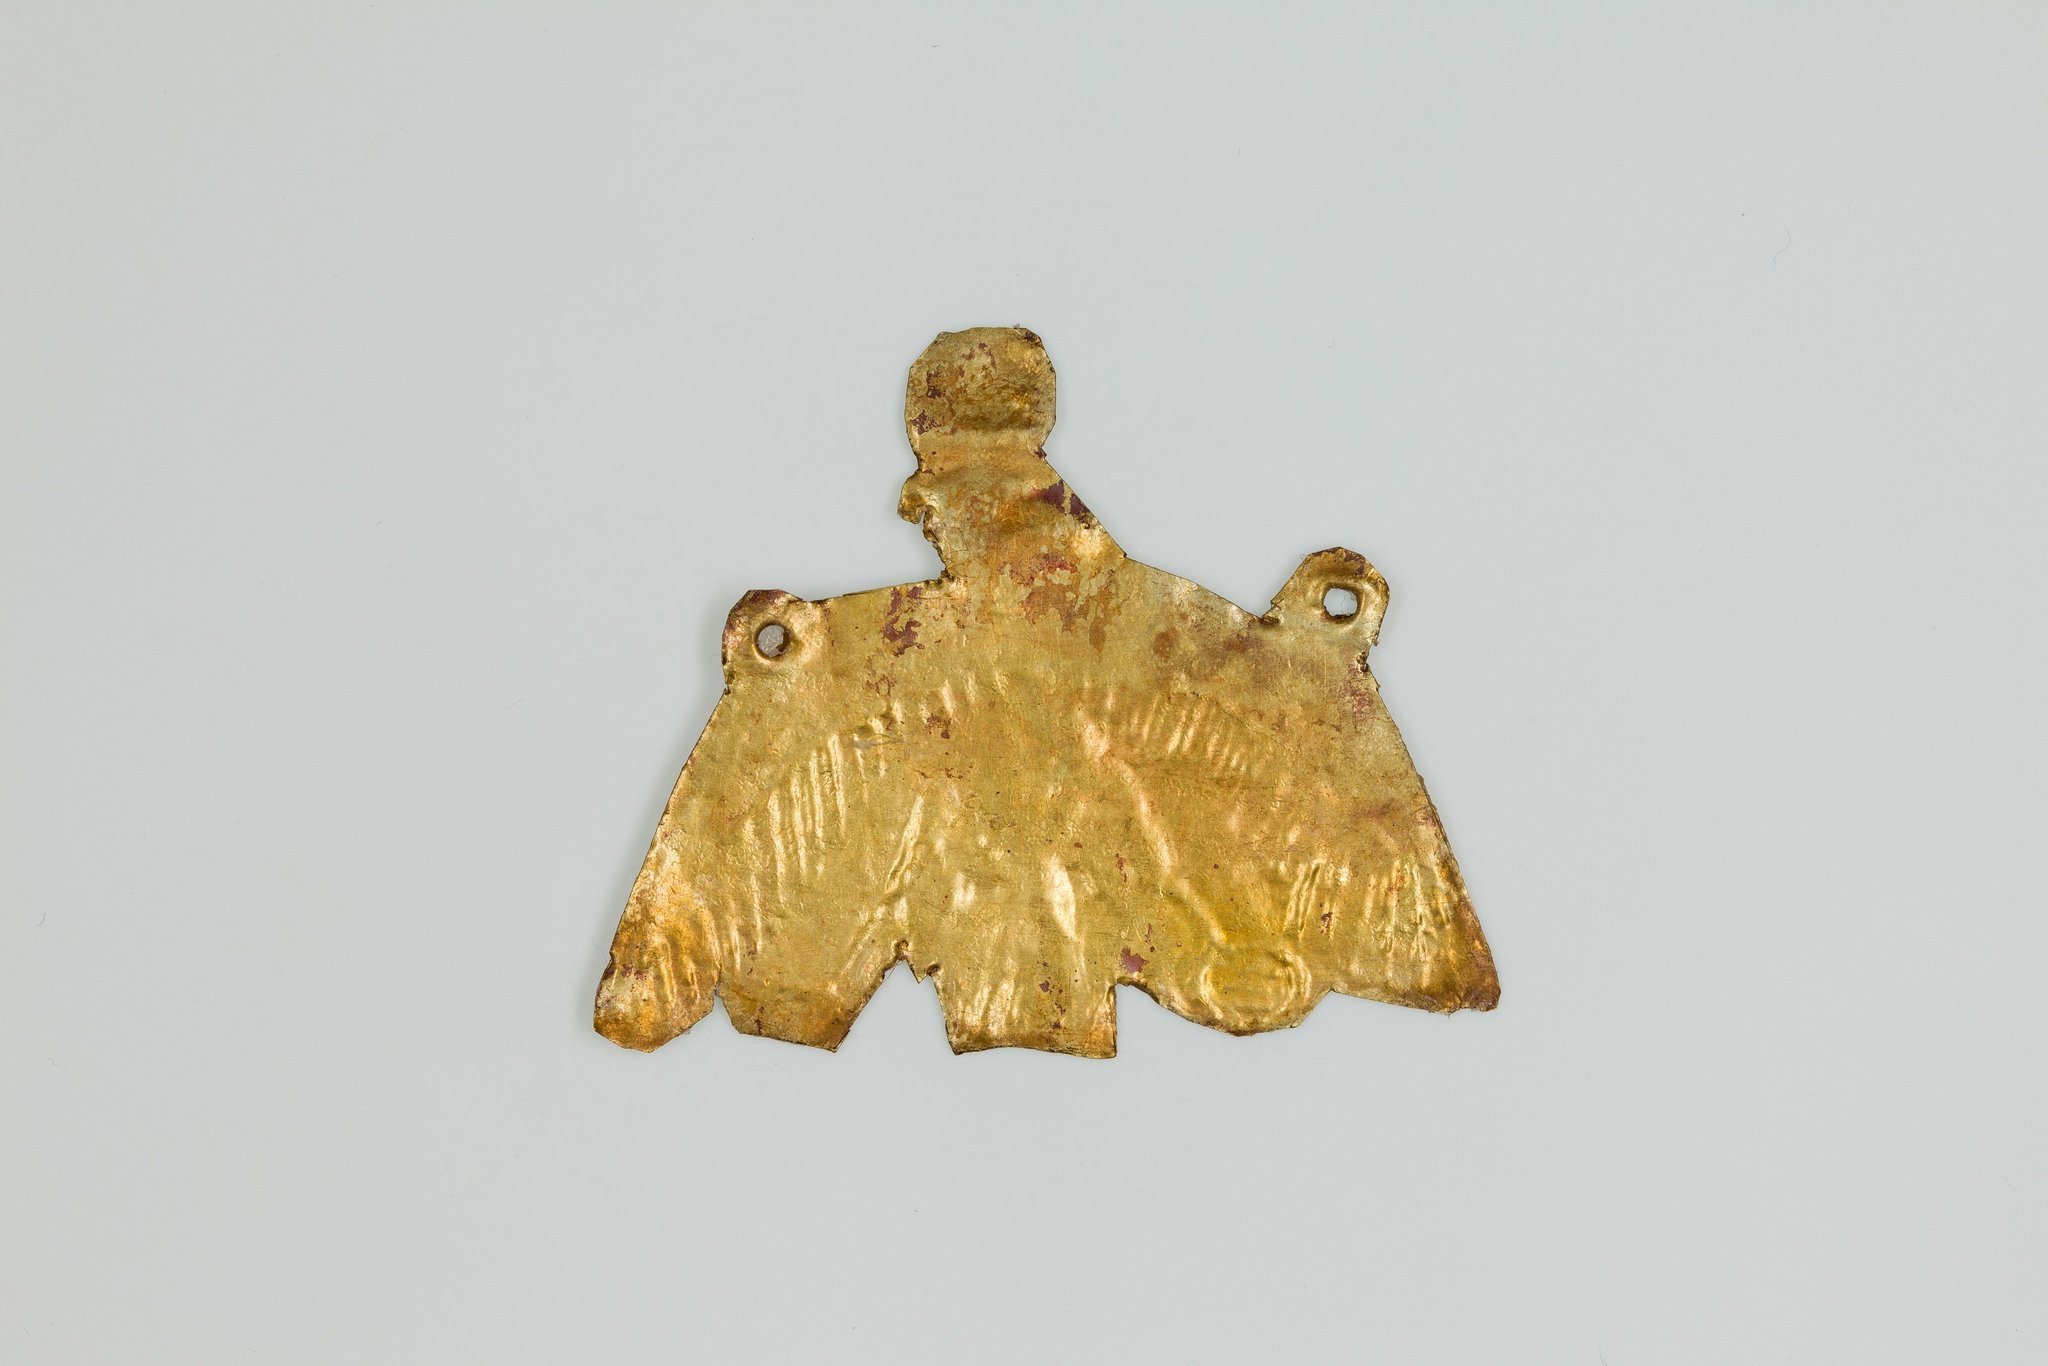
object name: amulet, falcon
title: Falcon amulet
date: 664-380 BCE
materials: gold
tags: falcons